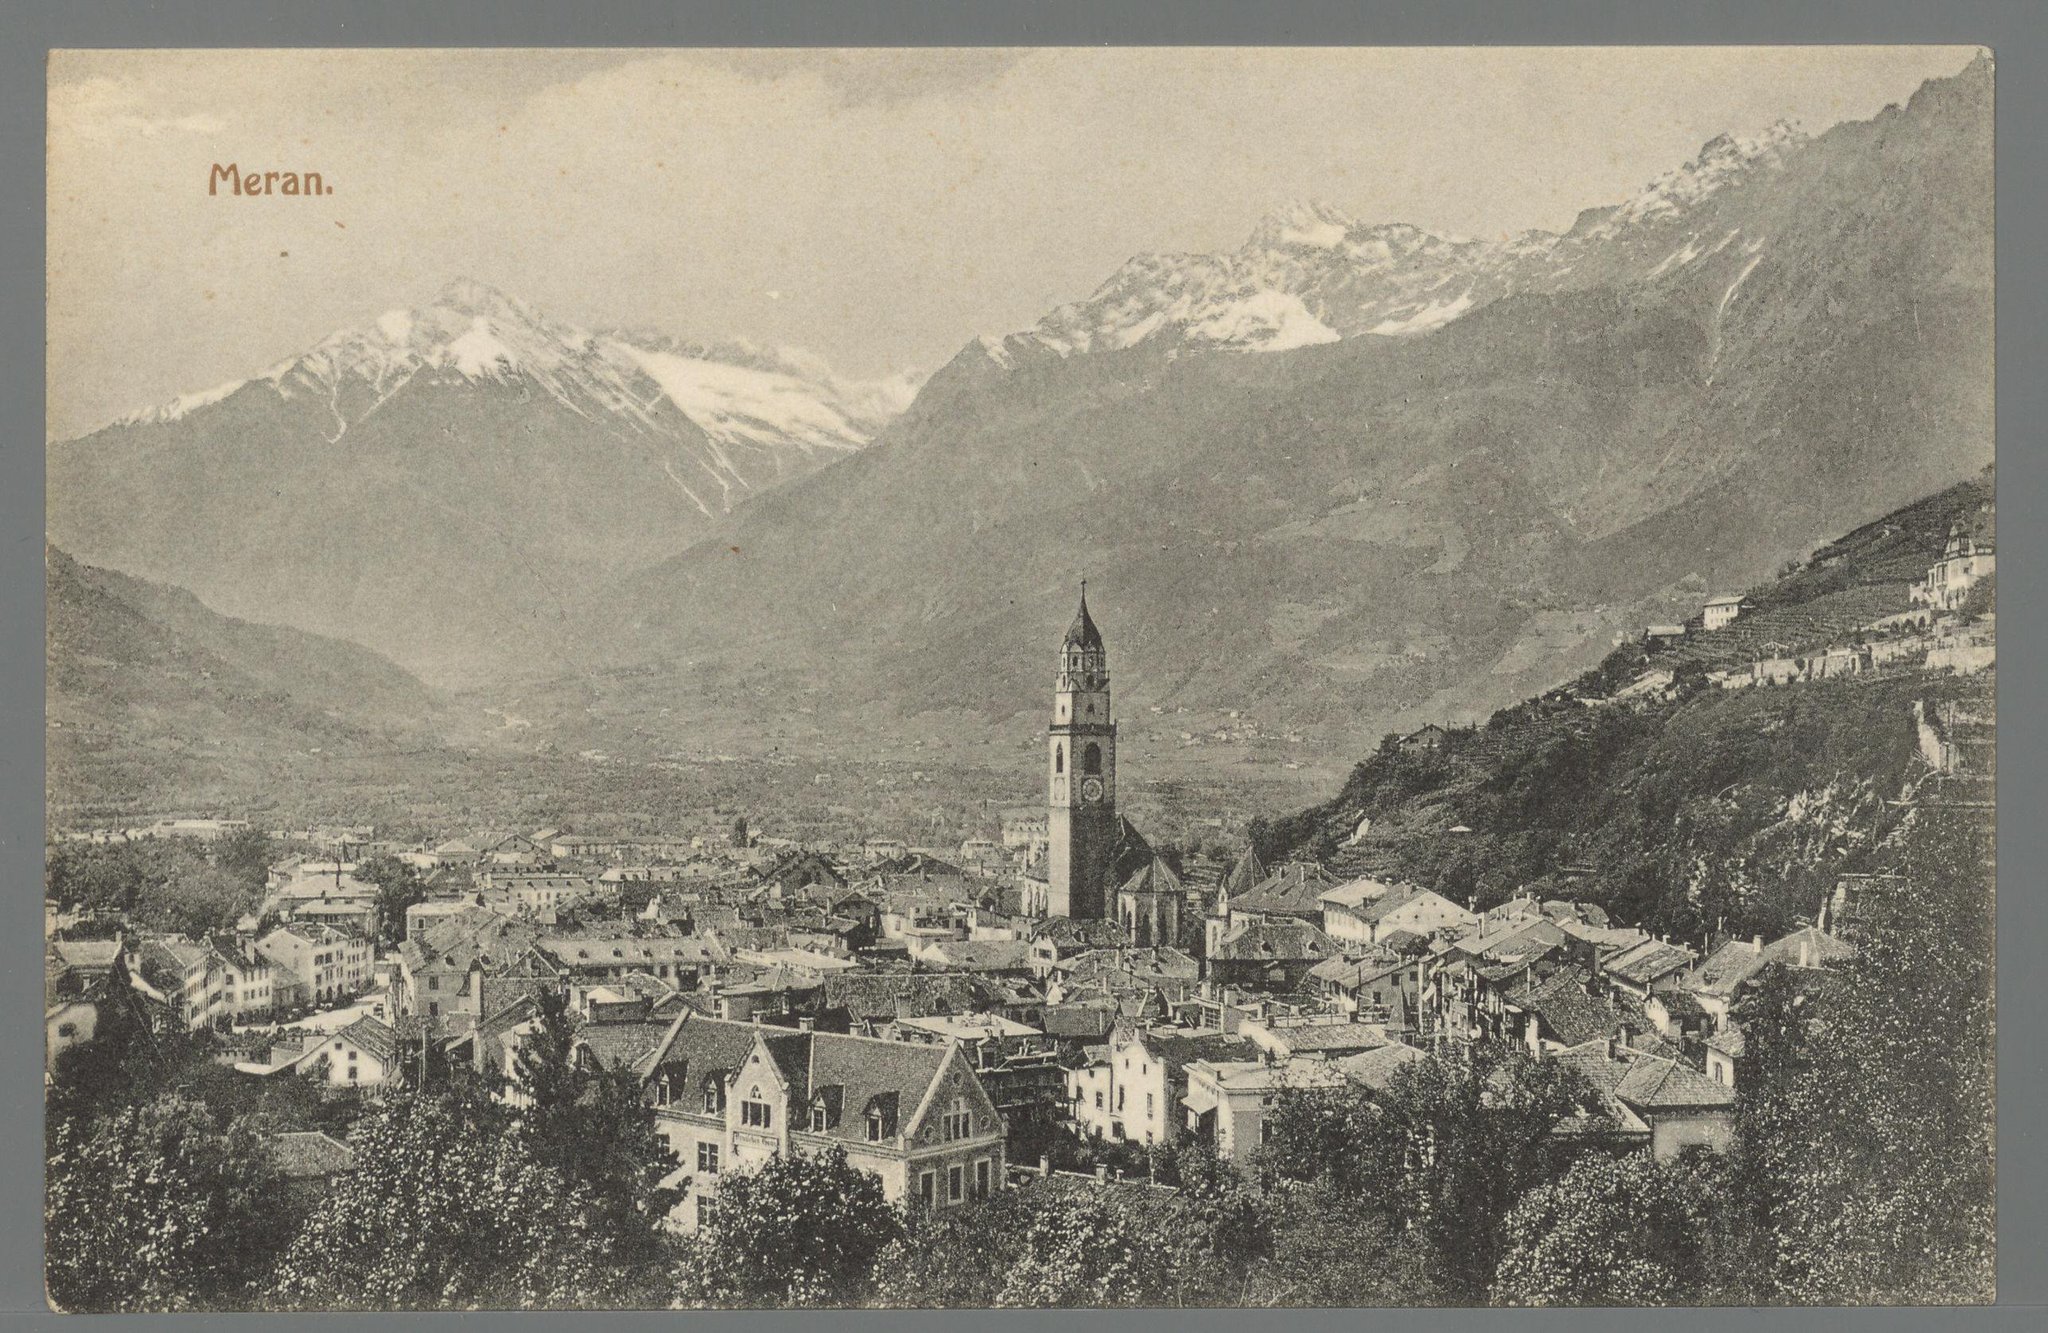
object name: ansichtkaart, prentbriefkaart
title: Meran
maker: Anonymous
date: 1907-1915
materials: cardboard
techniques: photograph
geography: salzburg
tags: mountain-range, snow peaks, prospect of city, town panorama, silhouette of city